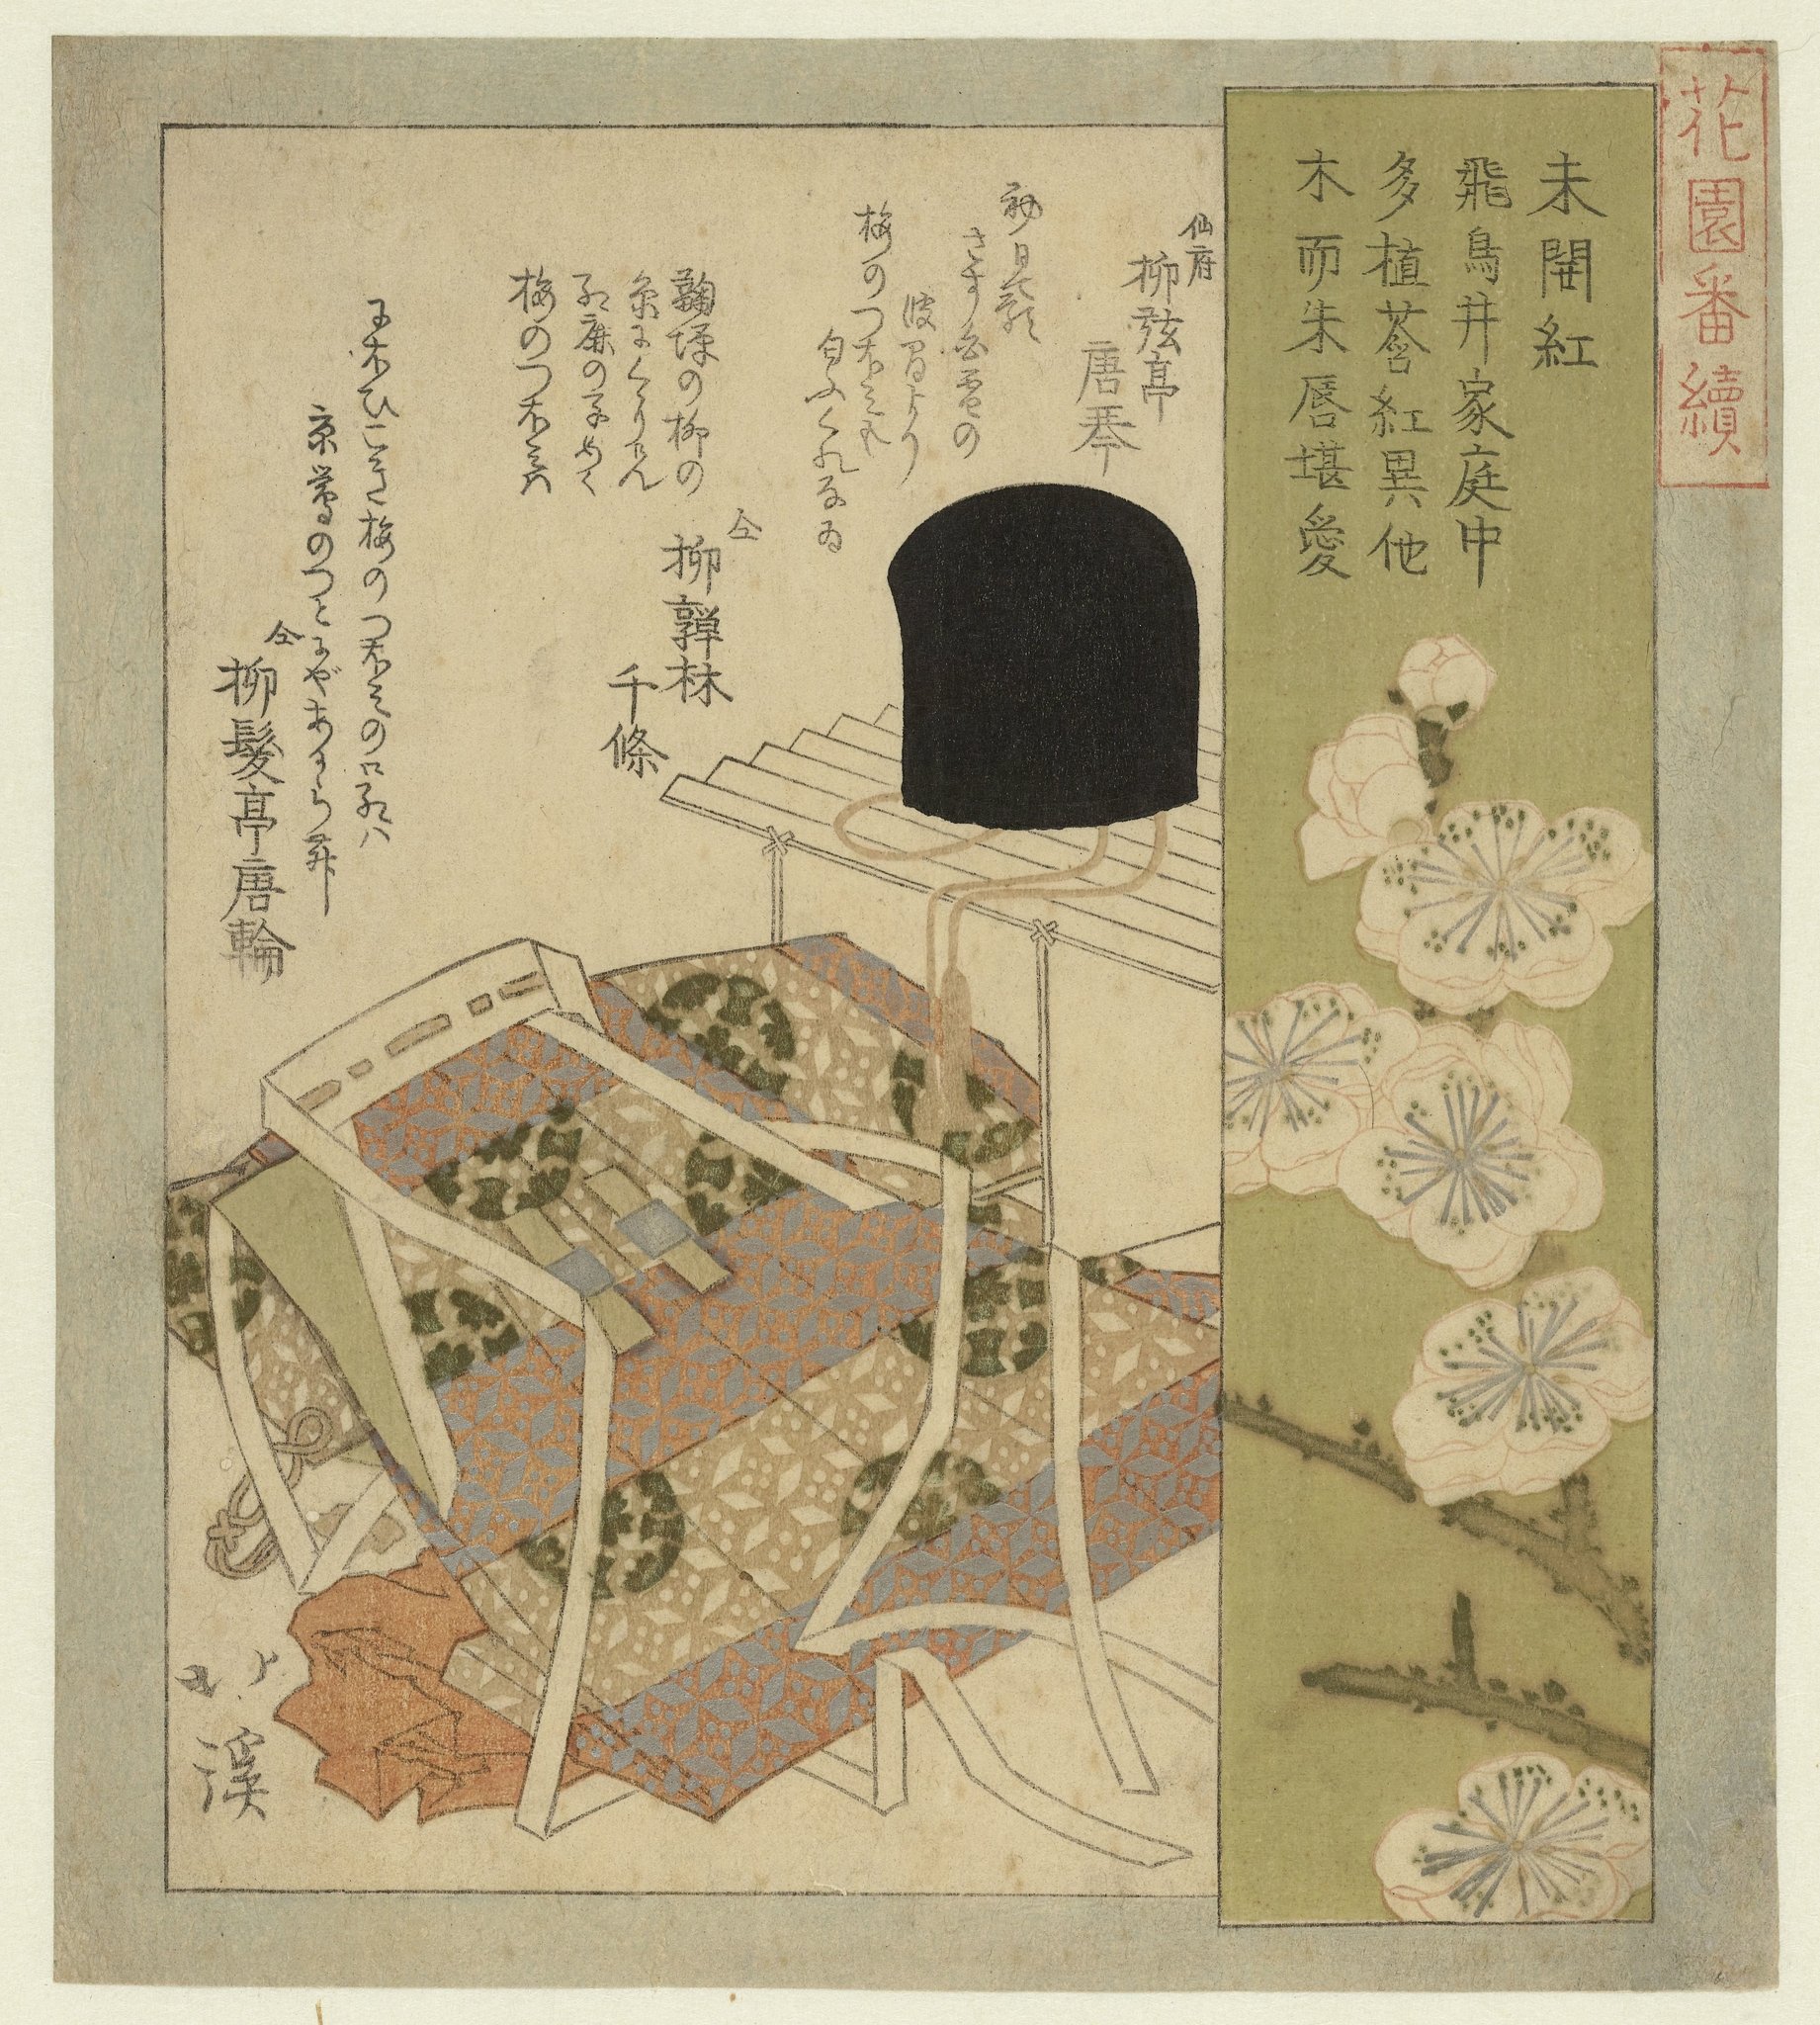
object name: surimono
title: Hanazono bantsuzuki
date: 1823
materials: paper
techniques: woodcut, polish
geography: japan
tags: clothes for official occasions, head-gear, plants; vegetation (+ flowers, blossom, blossoming)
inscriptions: collector's mark, verso, stamped: Lugt 2228, collector's mark, passe-partout, bottom left, printed: JABdH with a rooster.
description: Een surimono is een luxe uitgevoerde prent waarop beeld met één of meerdere gedichten gecombineerd is. Bij het drukken van een surimono werd vaak gebruik gemaakt van dikker papier, blinddruk en metaal pigmenten, zoals koper- en zilverpoeder. De prenten werden vaak in opdracht van dichters gemaakt en als exclusief geschenk aan vrienden en relaties gegeven.